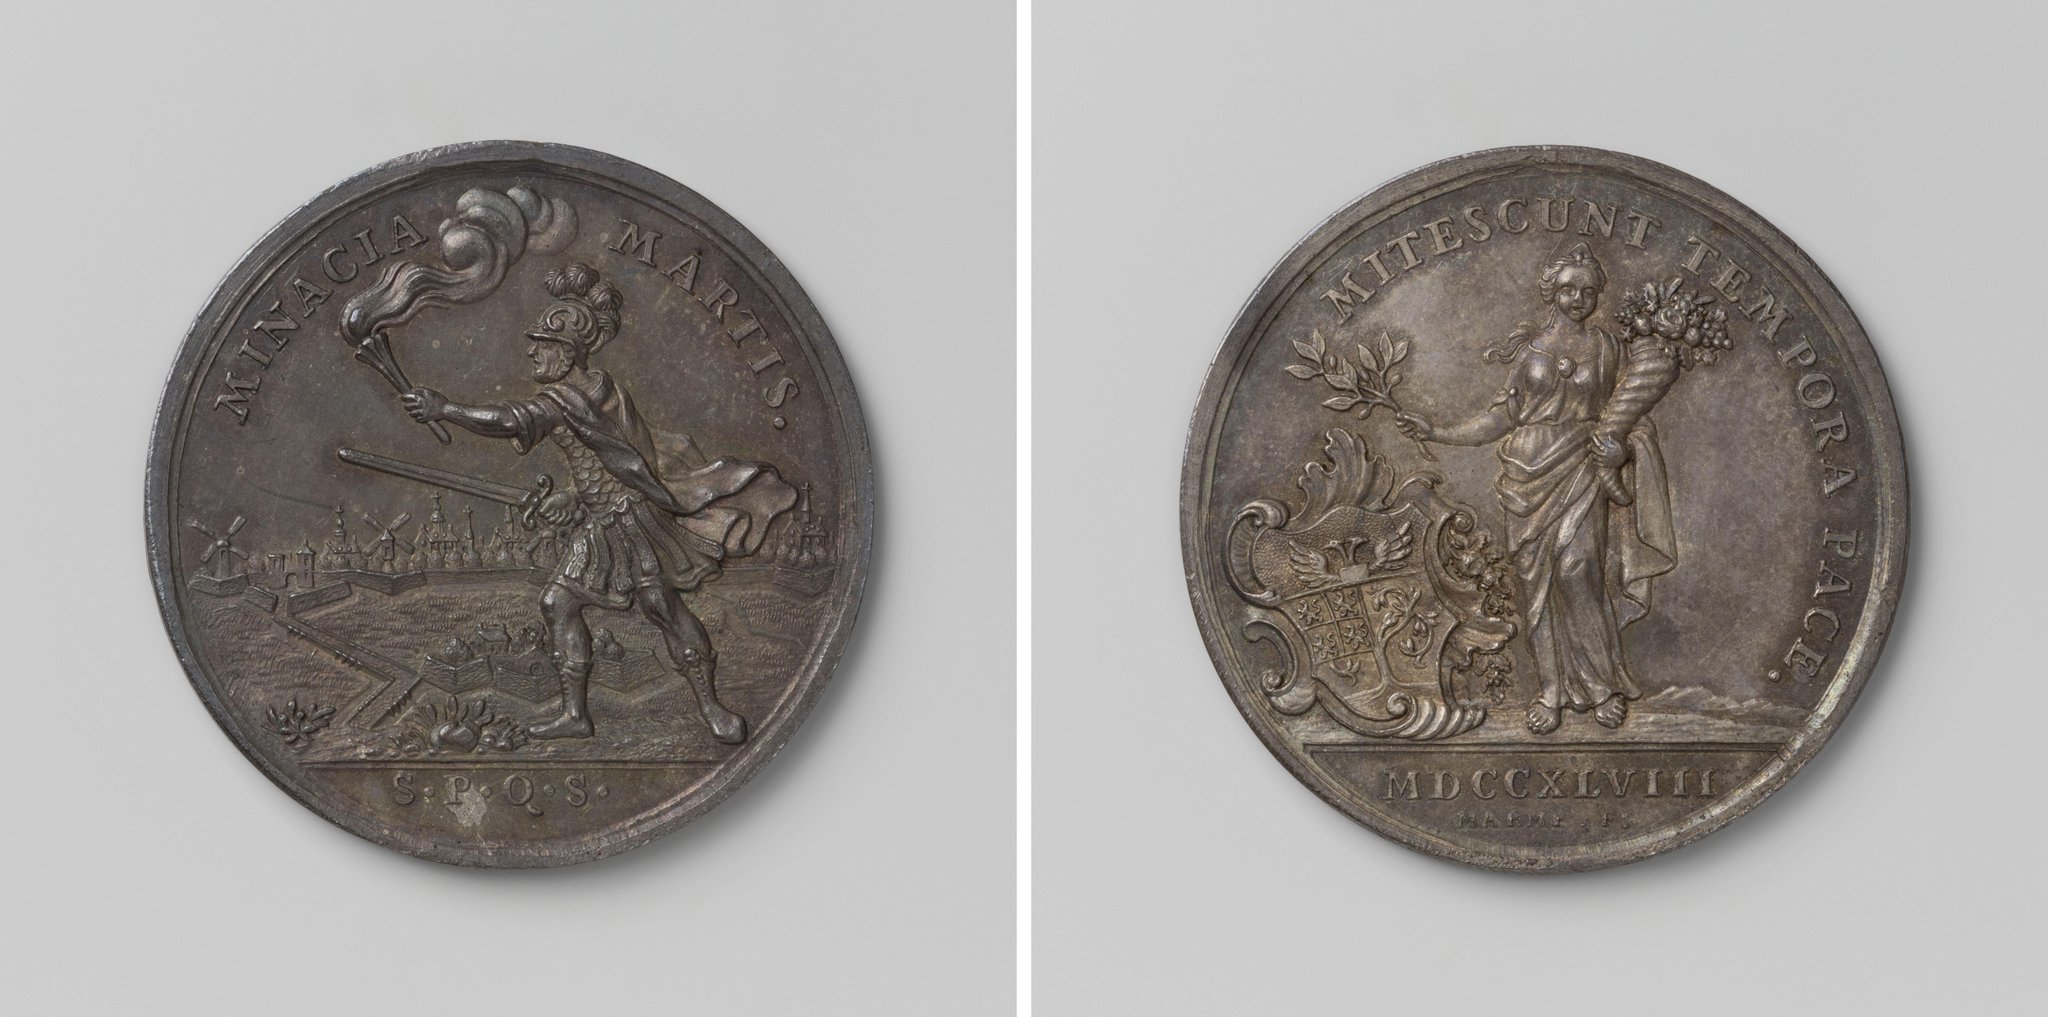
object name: council medal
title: 's-Hertogenbosch, vroedschapspenning op de vrede van Aken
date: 1748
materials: silver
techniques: striking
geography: den bosch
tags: den bosch